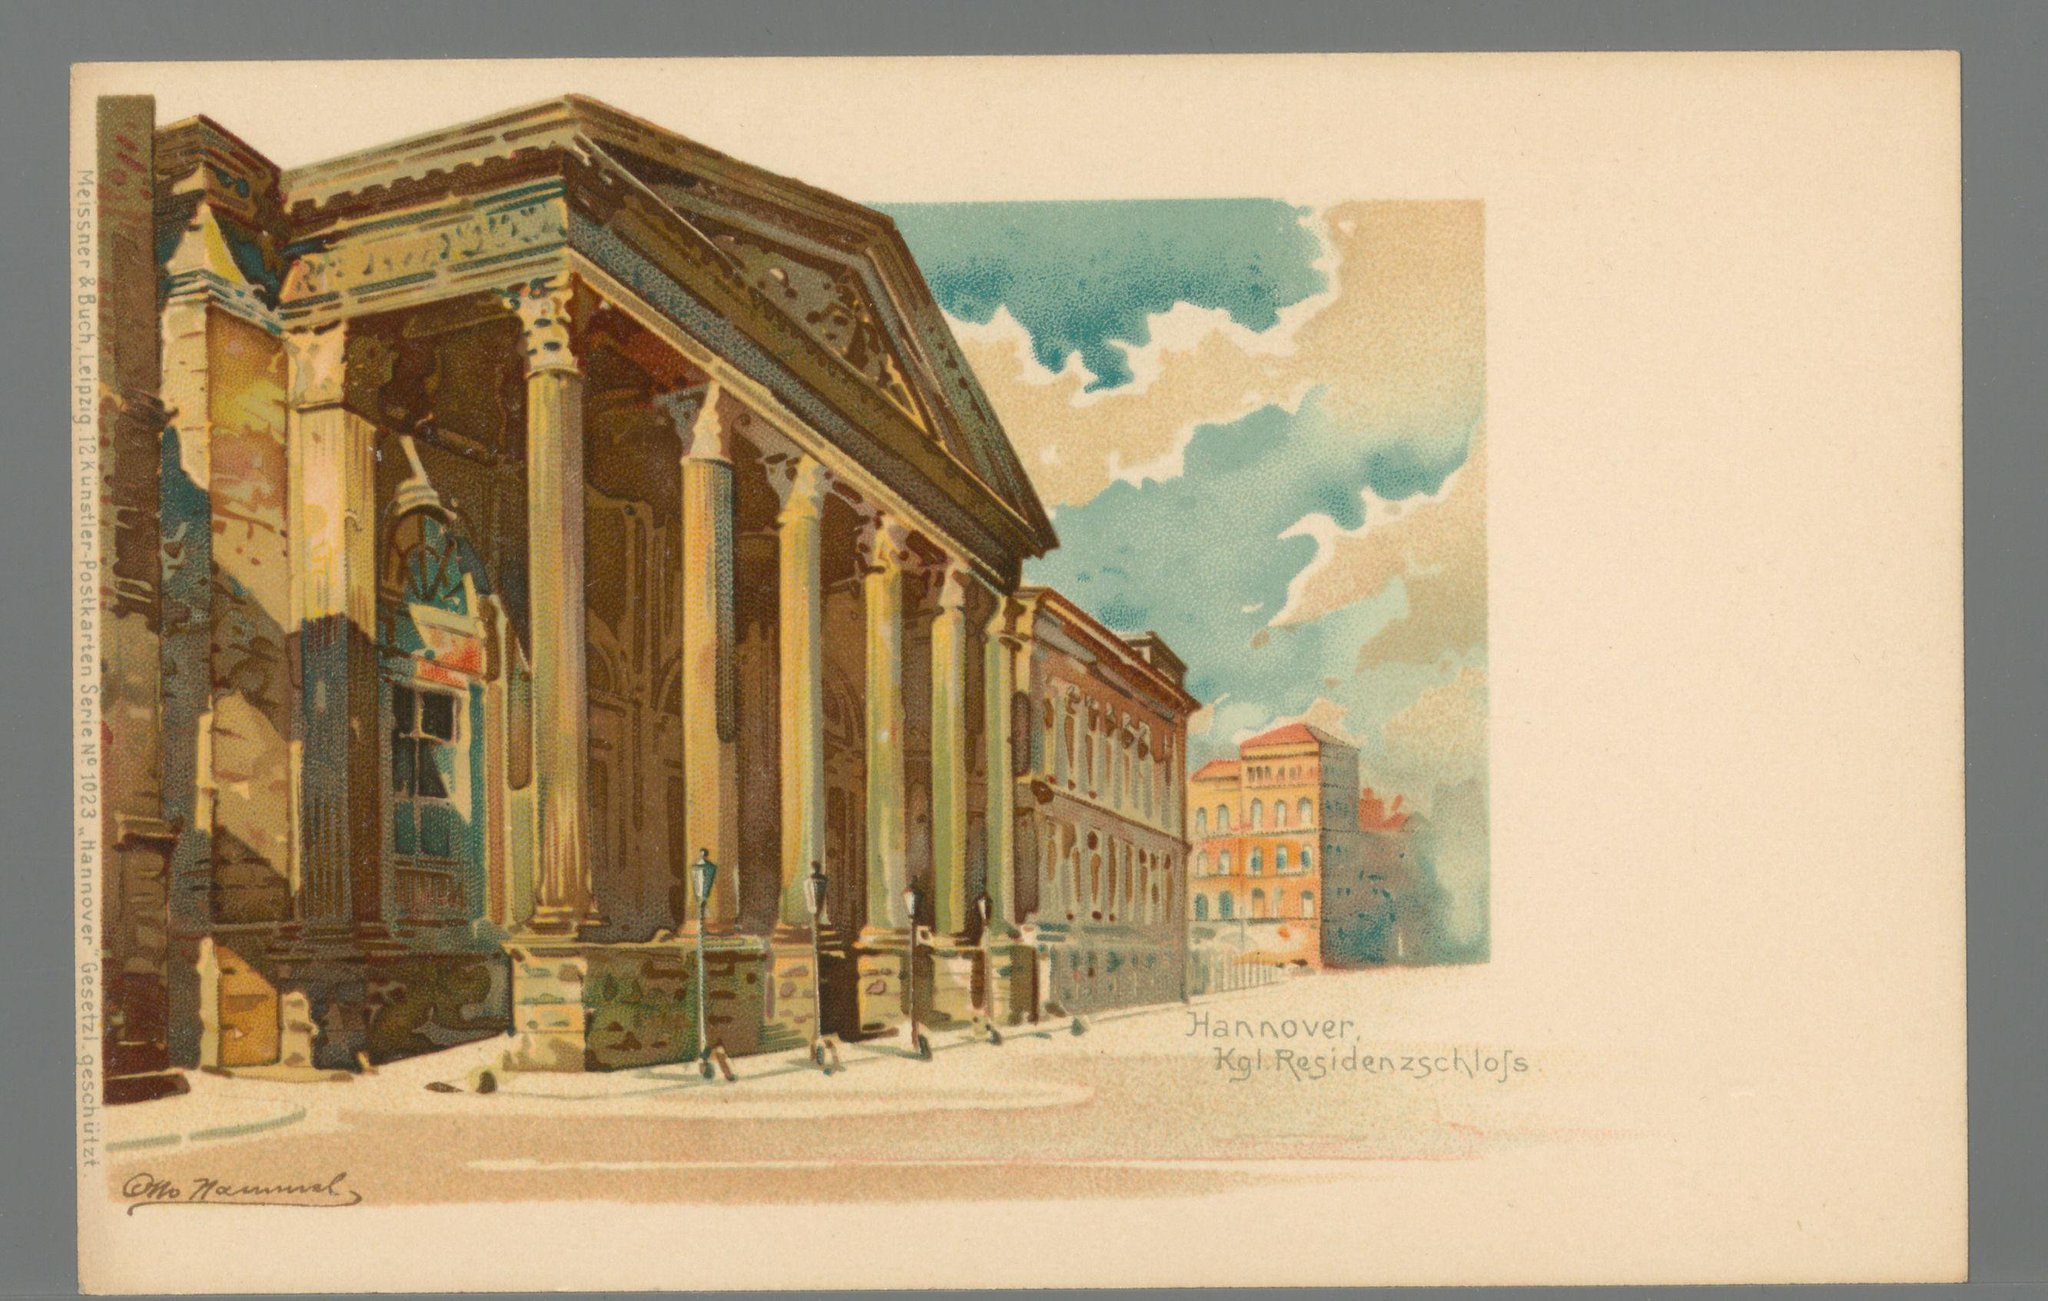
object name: print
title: Hannover, Kgl. Residenzschloss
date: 1898-1905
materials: cardboard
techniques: lithograph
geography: leipzig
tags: castle